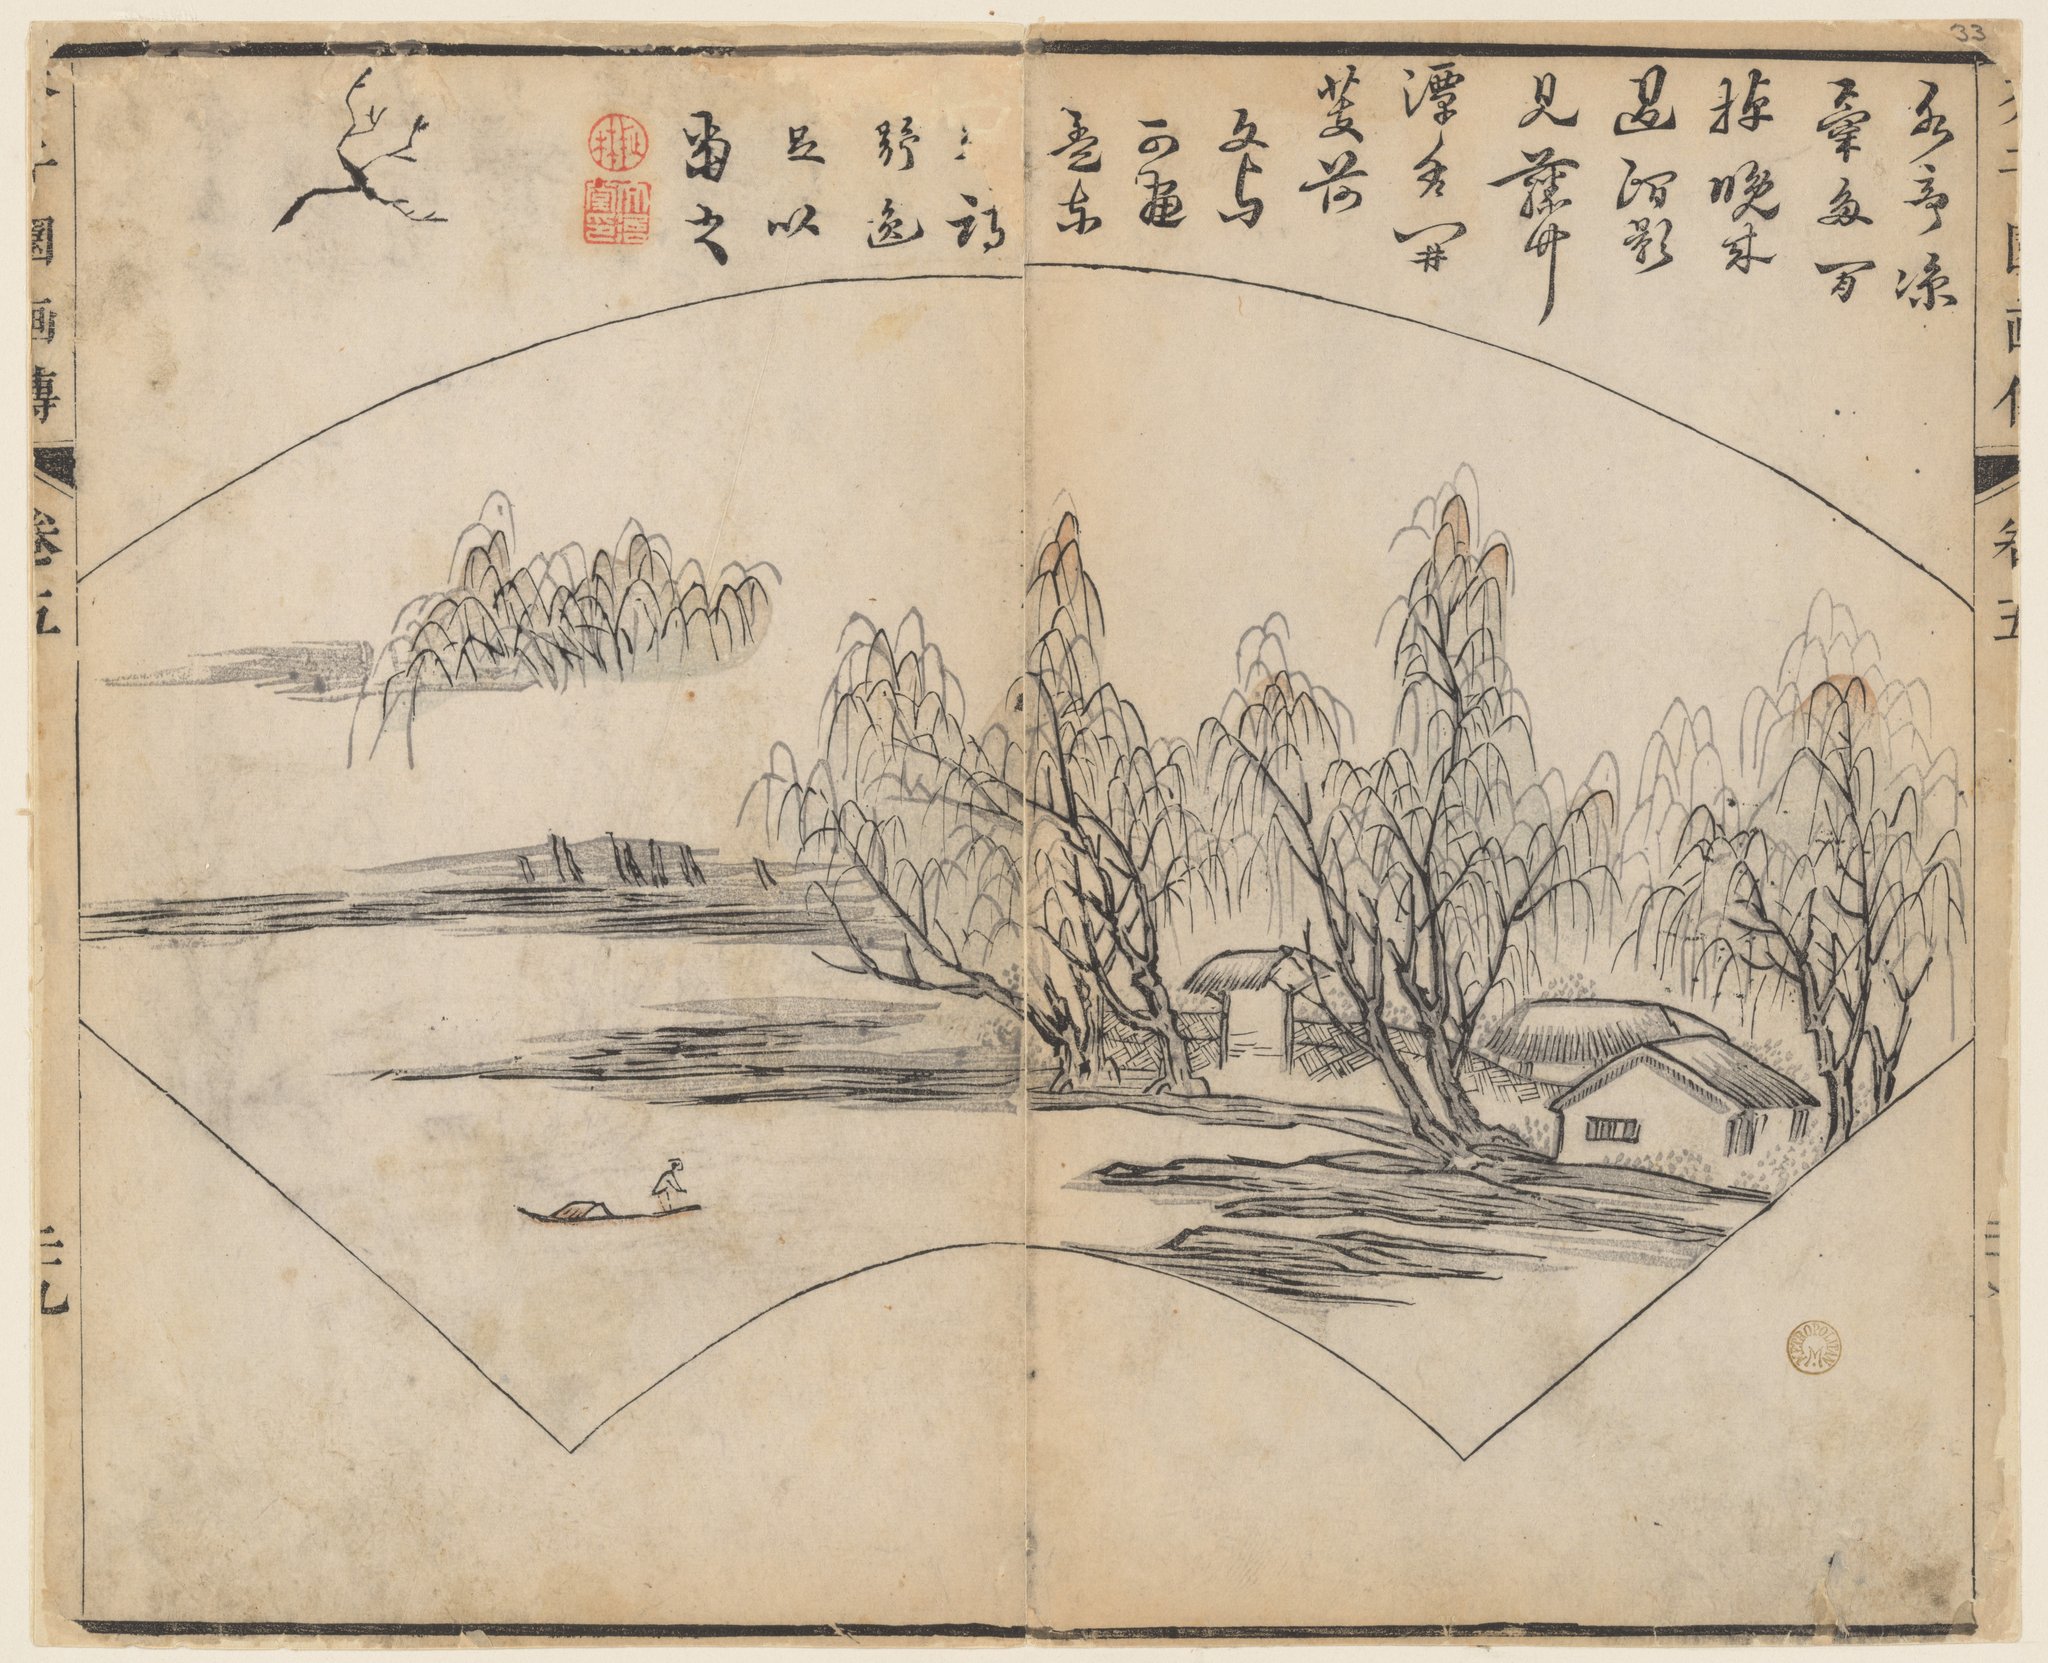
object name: print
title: Page from the Mustard Seed Garden Manual of Painting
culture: chinese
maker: wang gai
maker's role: artist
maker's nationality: chinese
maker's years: 1645-1710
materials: ink, paper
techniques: woodblock print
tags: landscapes